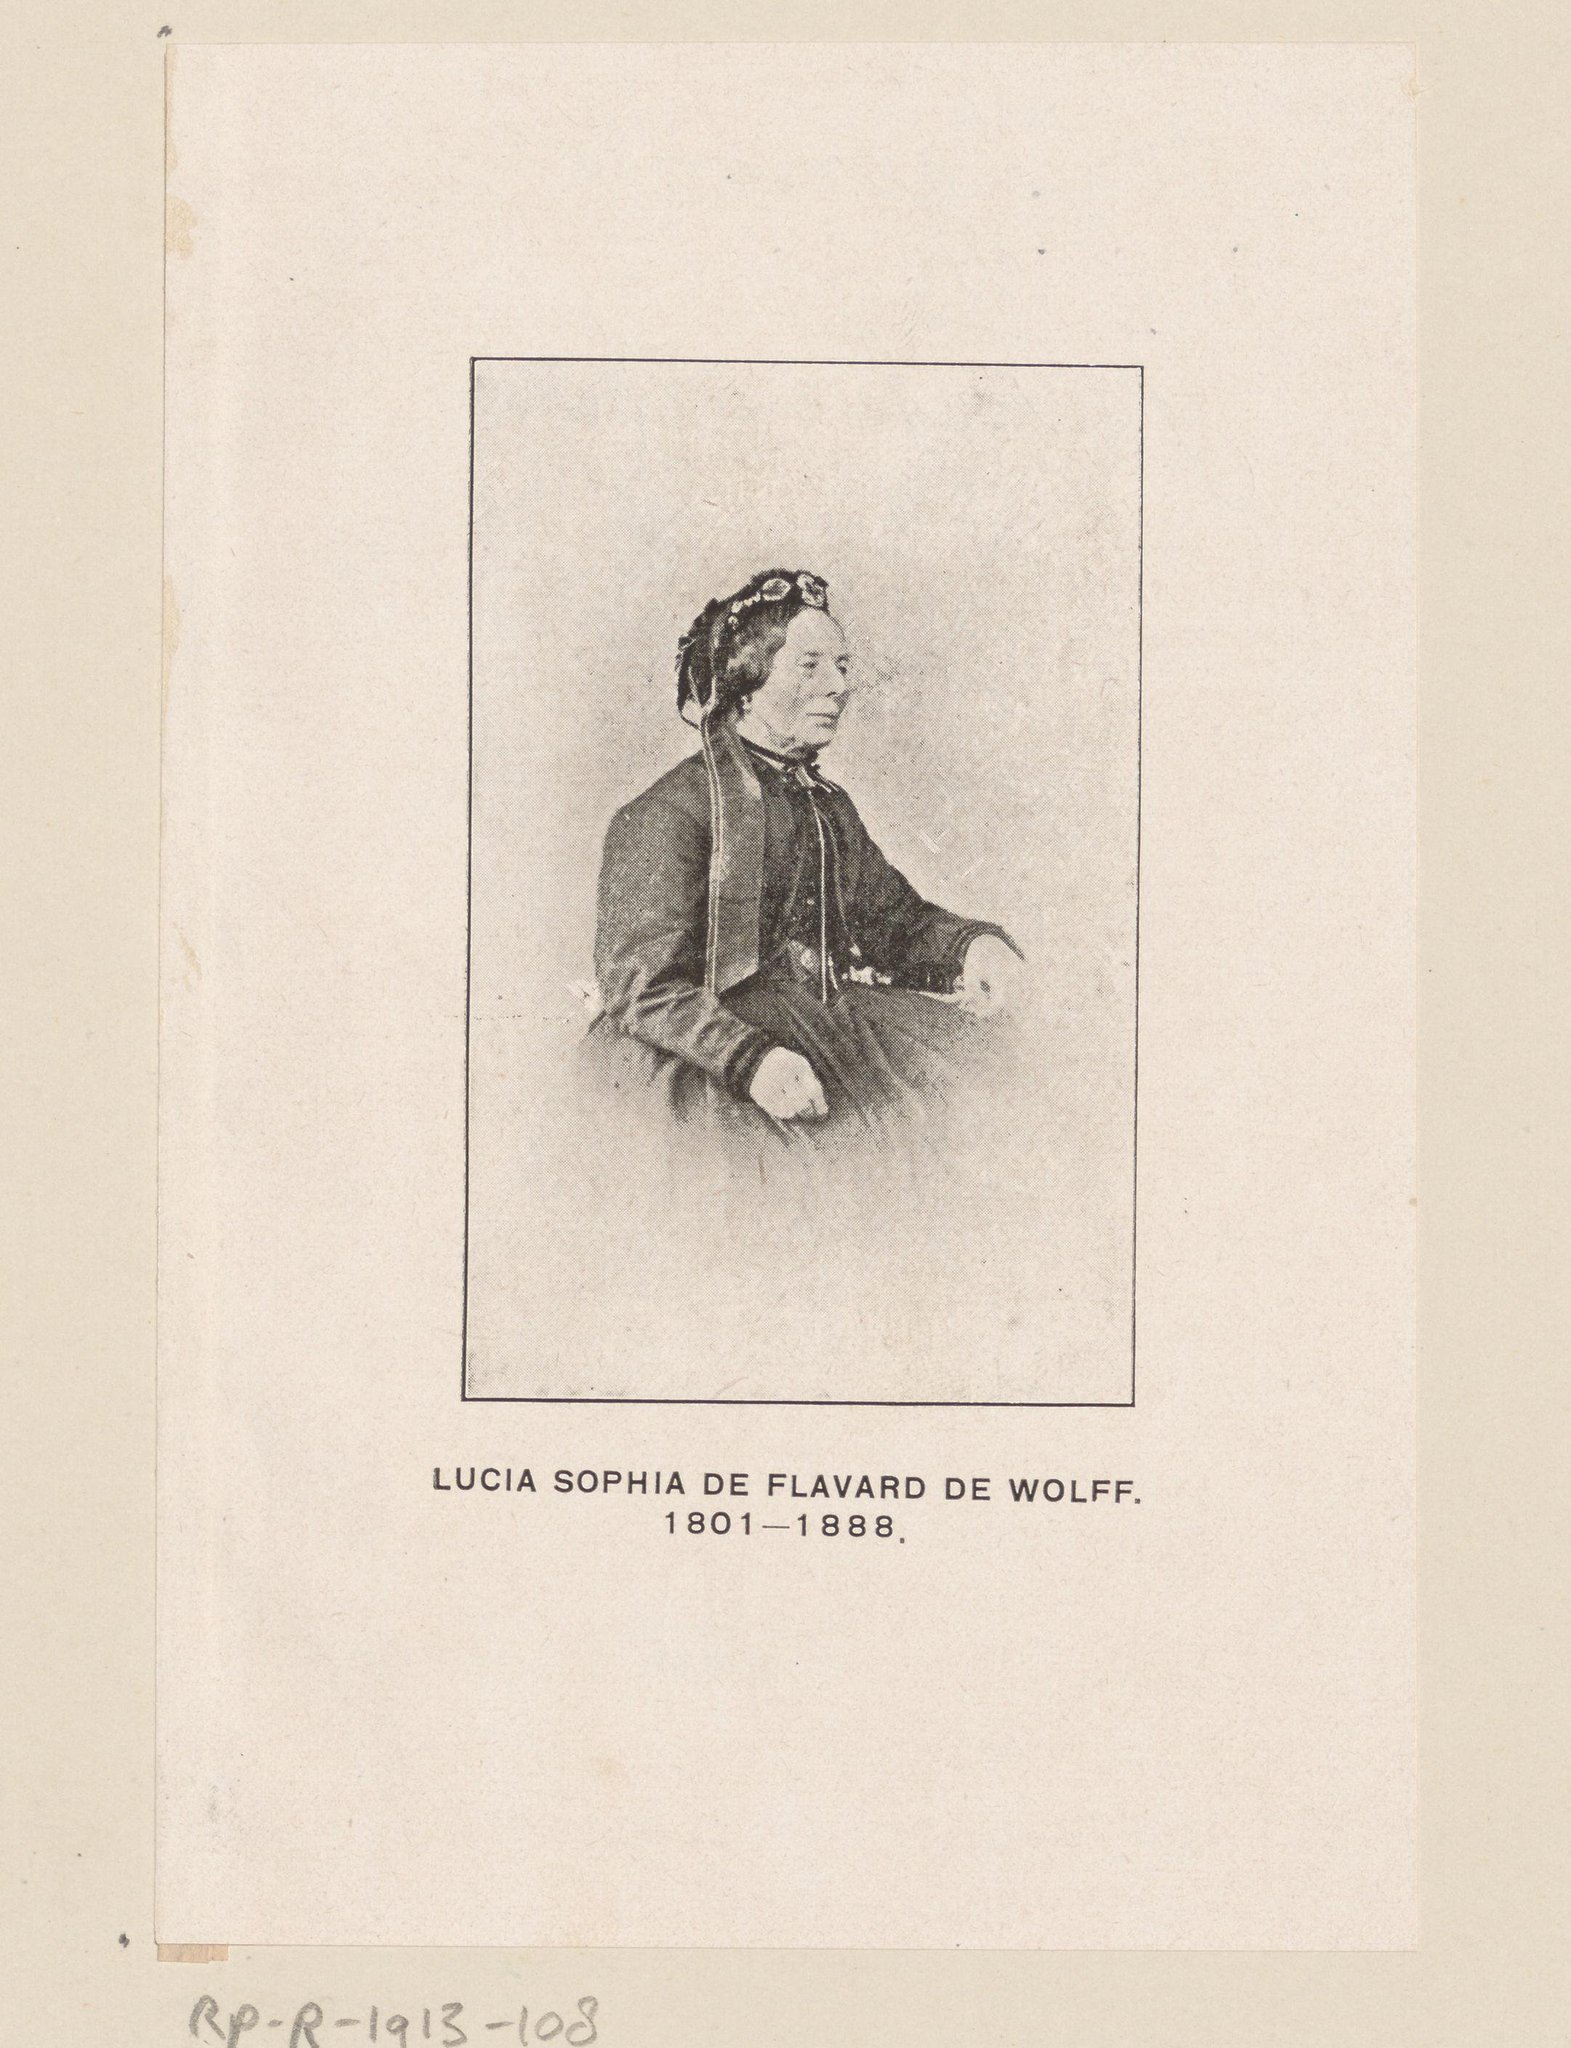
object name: reproduction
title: Portret van Lucia Sophia de Flavard de Wolff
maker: Anonymous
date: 1888-1913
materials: paper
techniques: autotype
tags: historical persons - bb - woman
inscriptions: inscription: ‘Echtgenoote van J.F.[...] v. Römer’, collector's mark: Lugt 2228